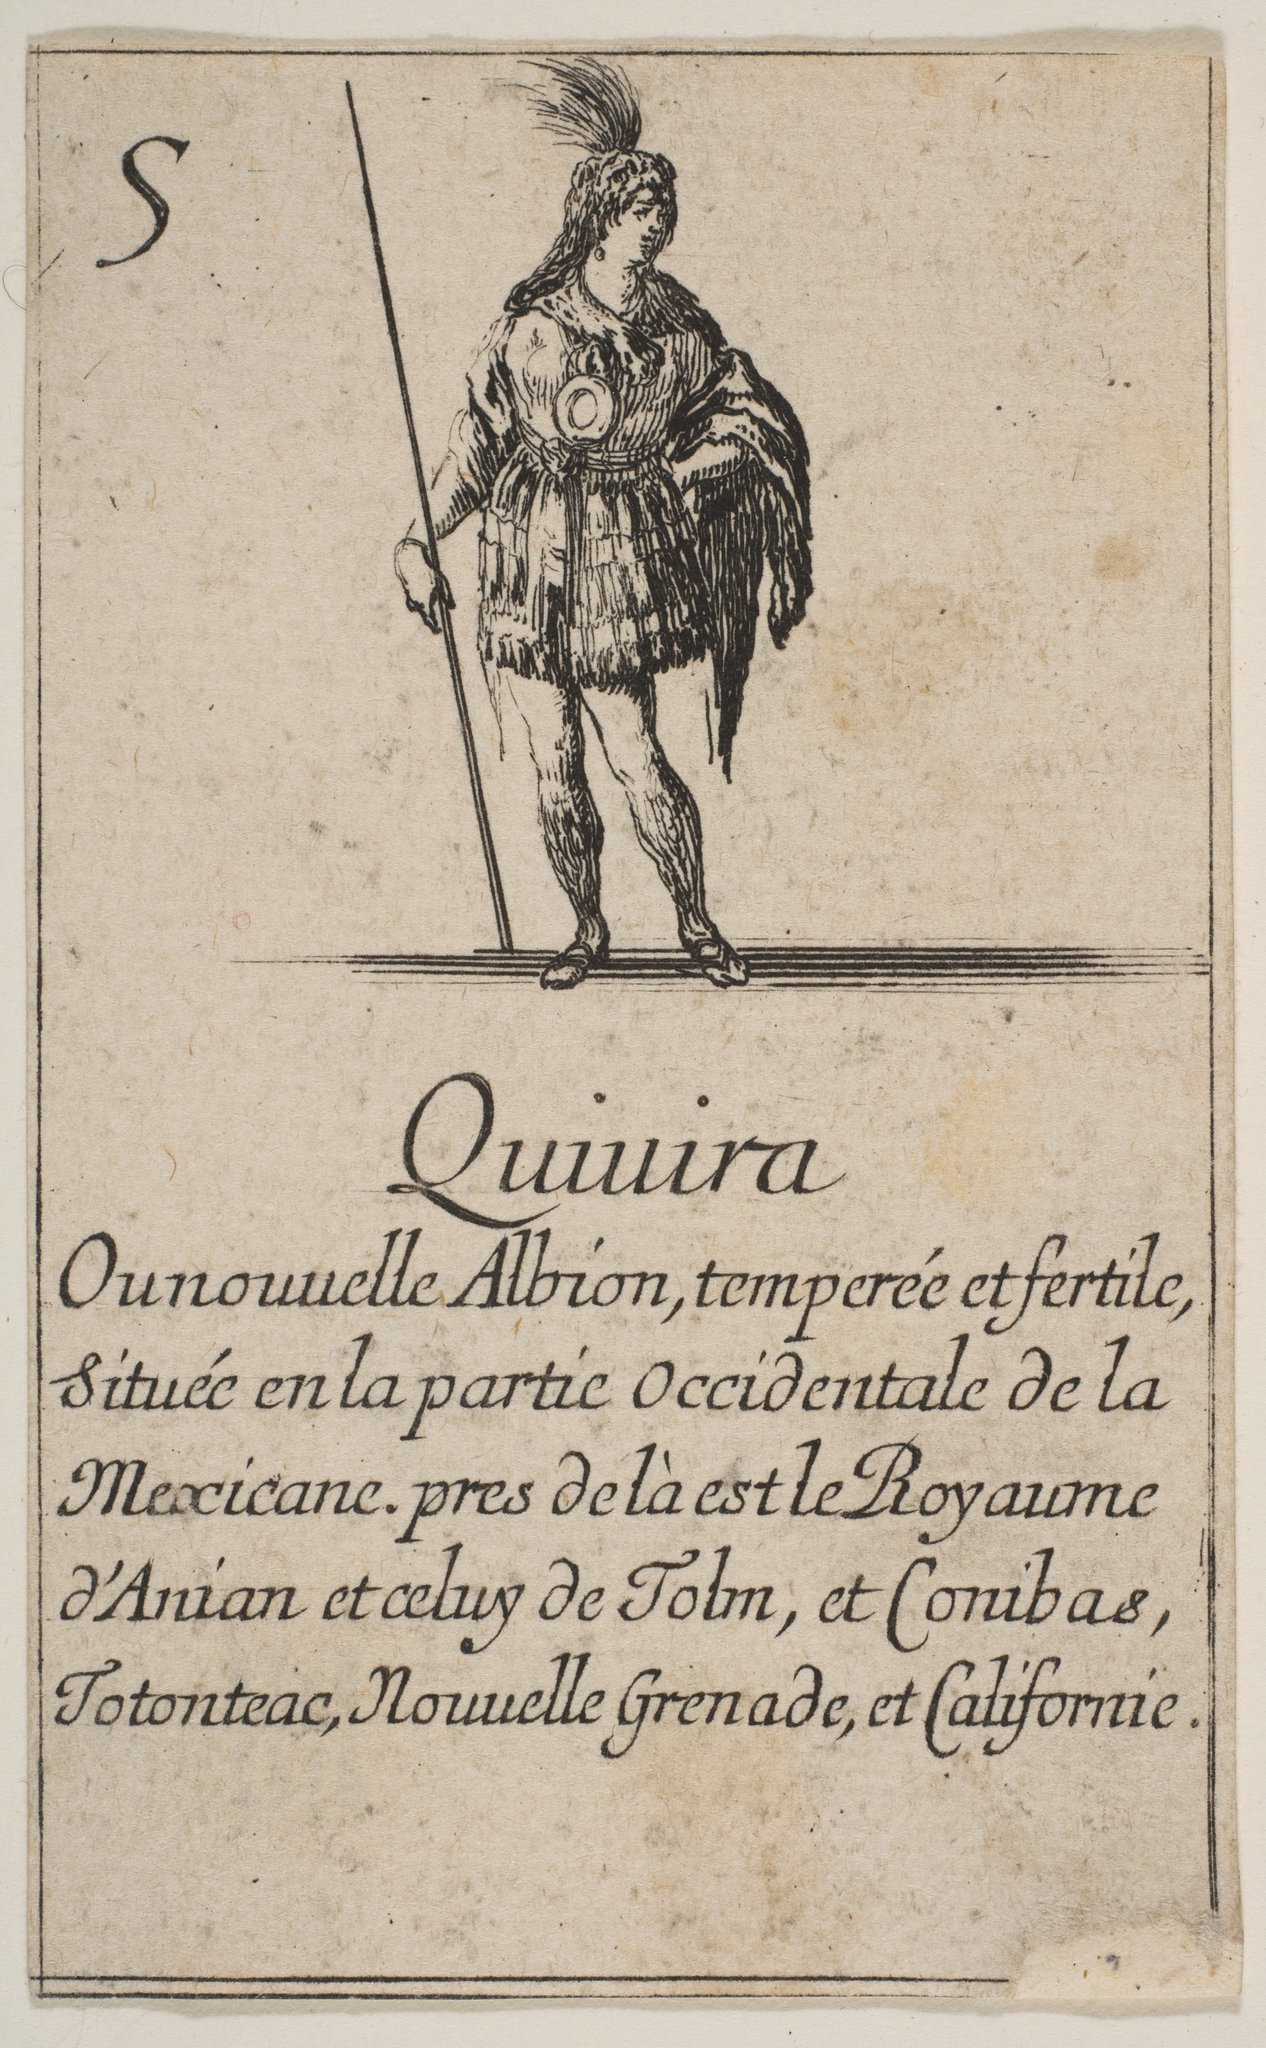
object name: print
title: Quivira, from the playing cards "Jeu de la Géographie"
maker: stefano della bella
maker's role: artist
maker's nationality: italian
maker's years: 1610-1664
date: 1644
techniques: etching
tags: men